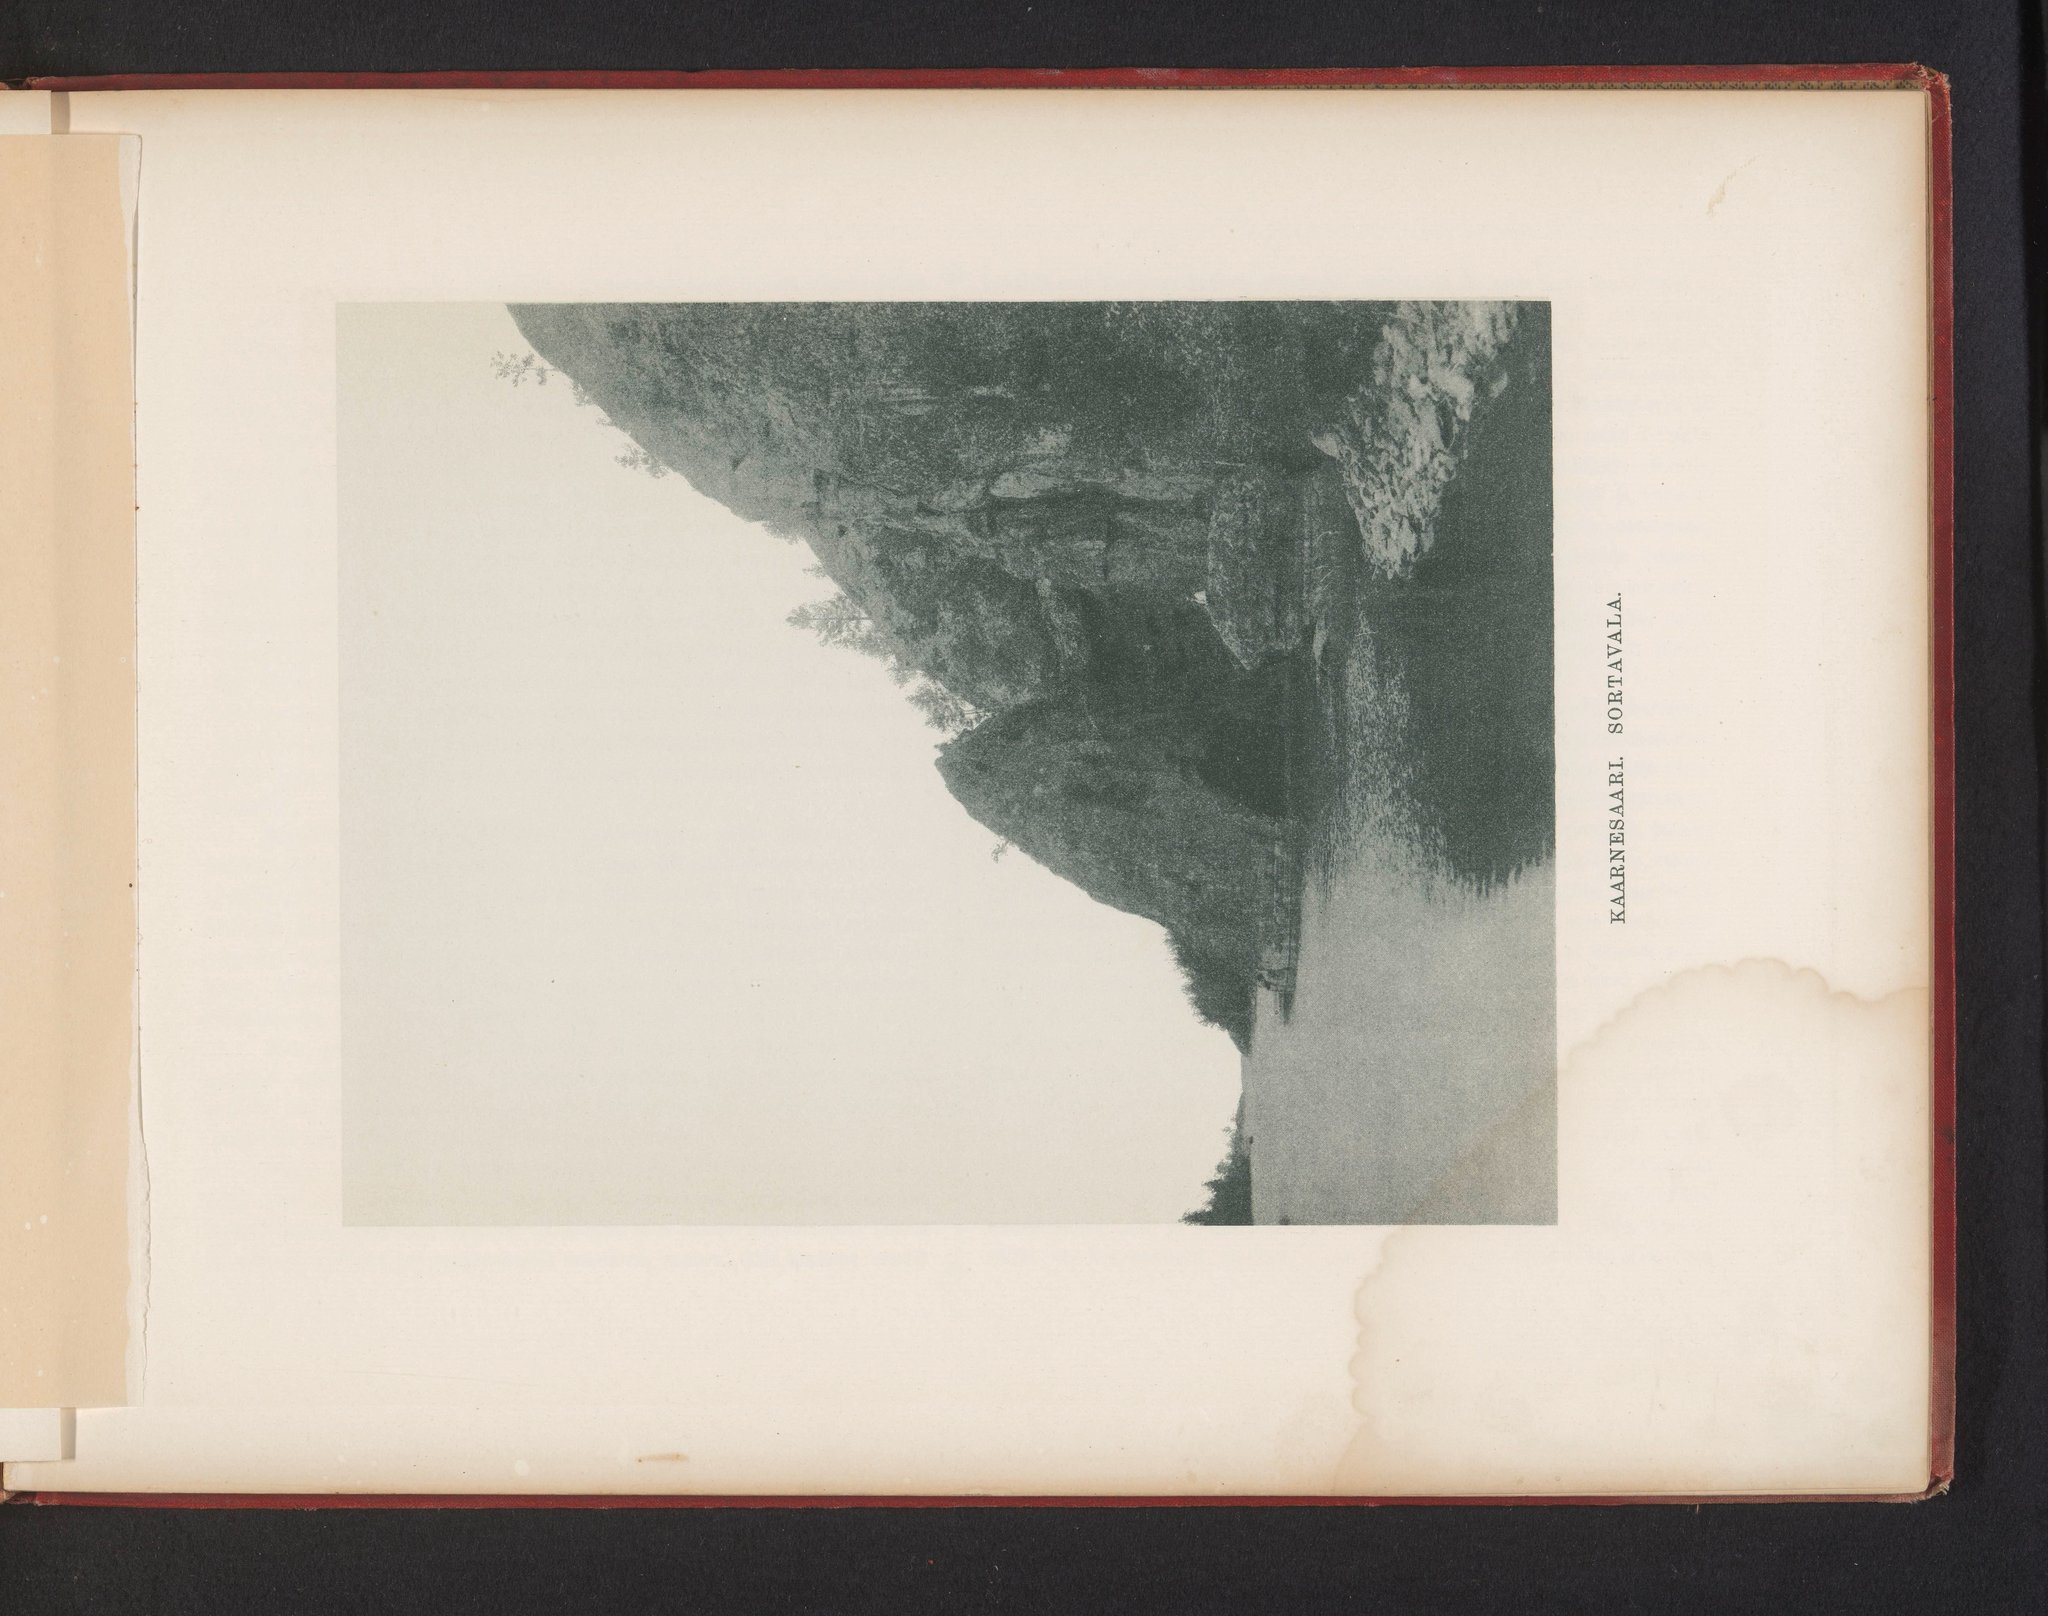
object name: page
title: Rotsen aan een water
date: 1888-1893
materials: paper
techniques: autotype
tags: trees, landscapes with waters, waterscapes, seascapes (in the temperate zone), rocks